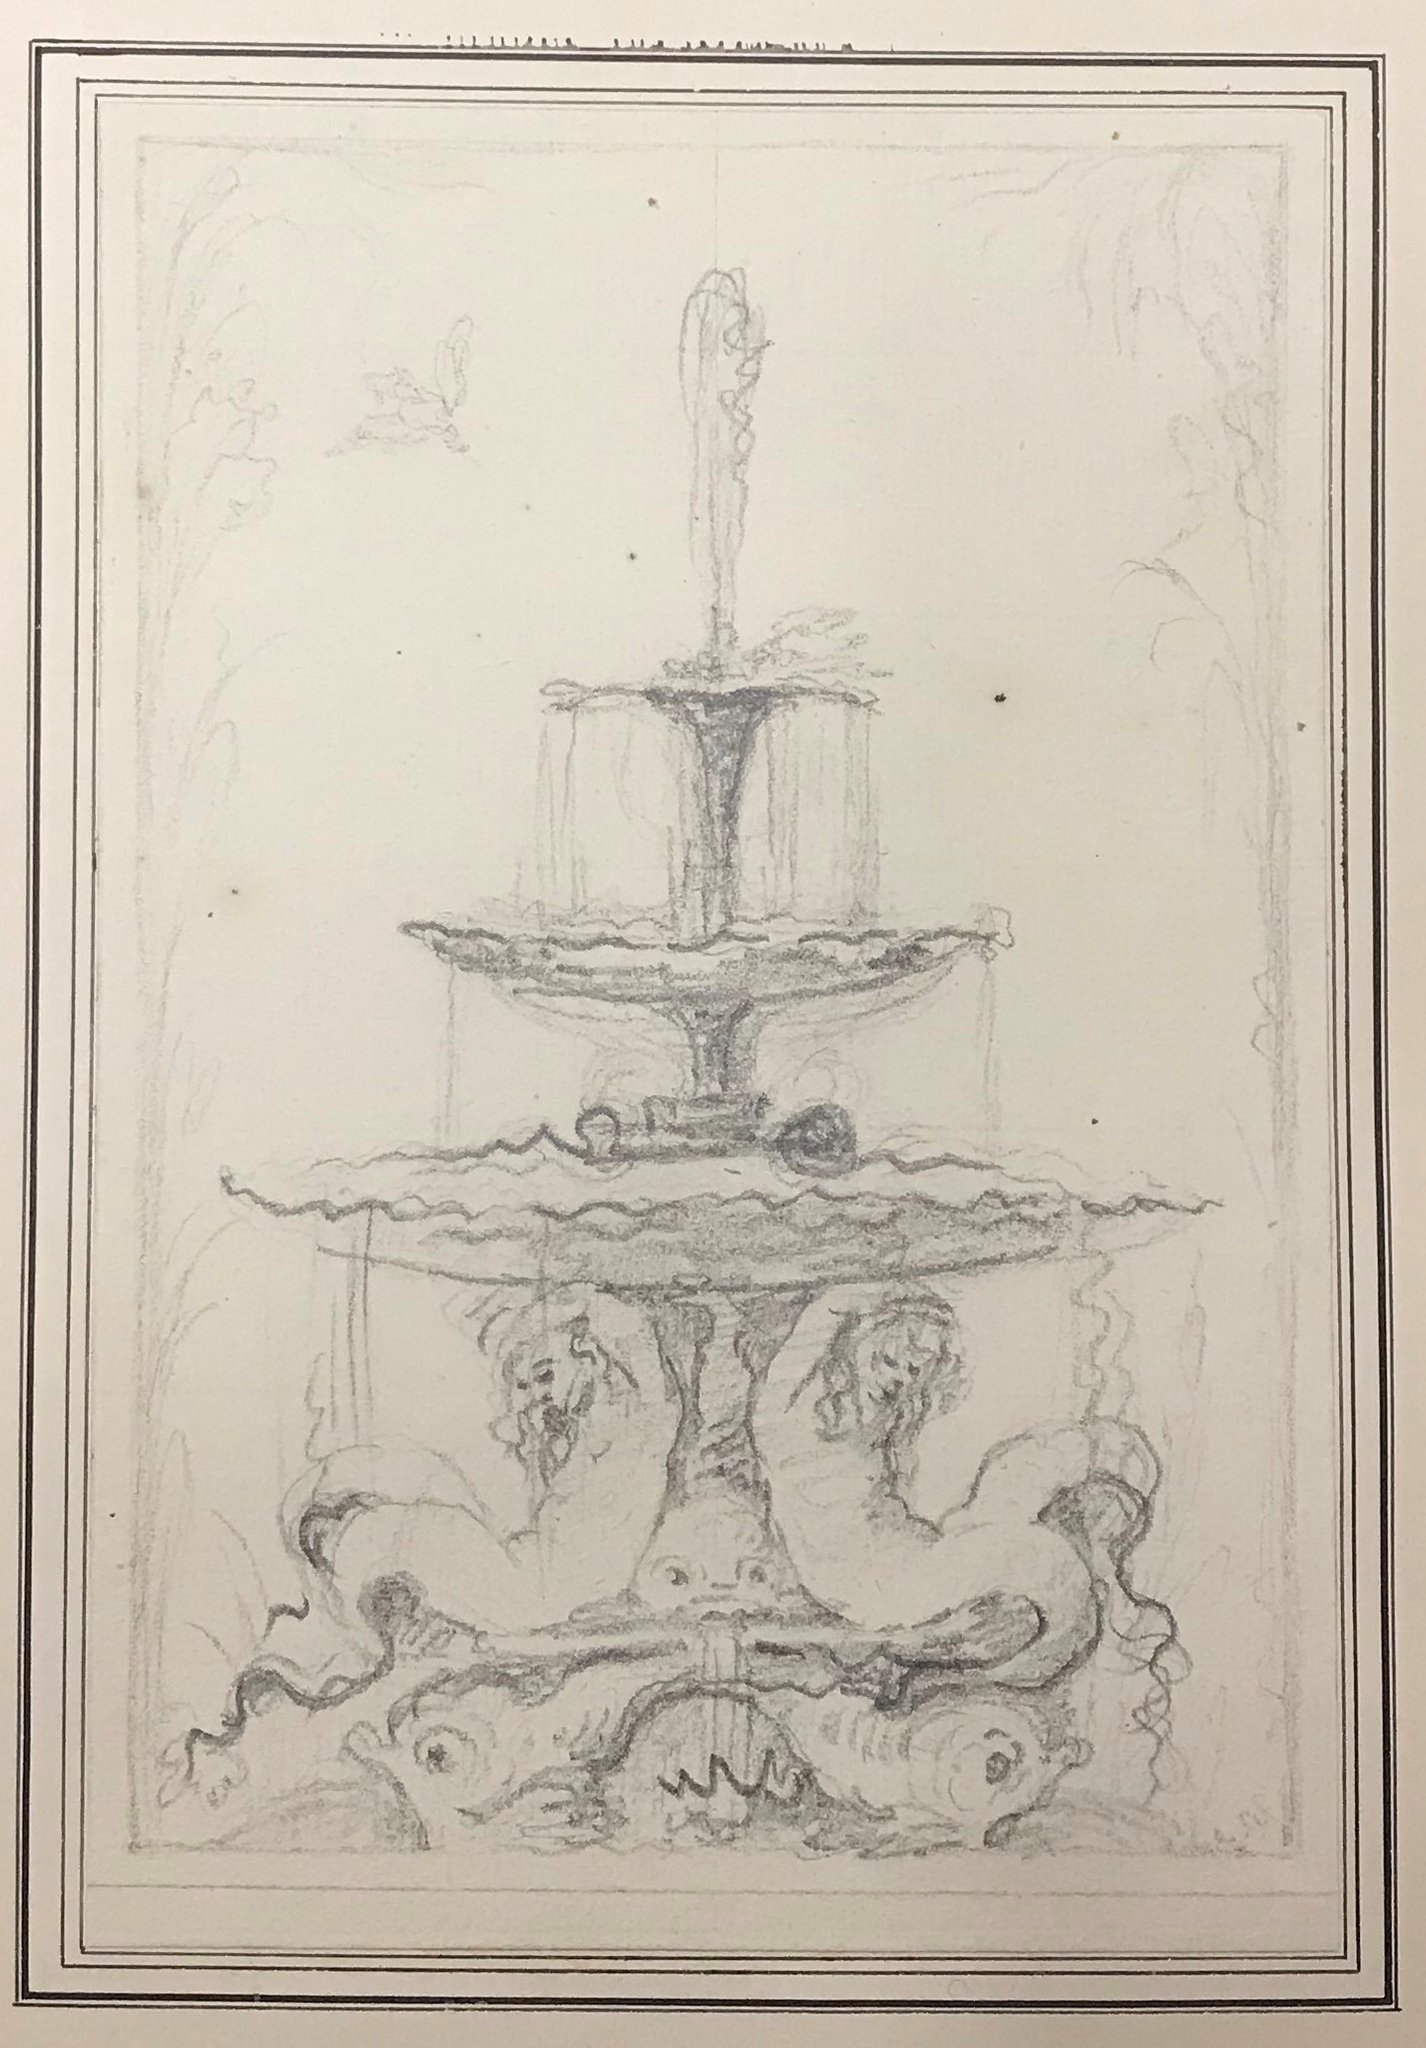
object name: album print ornament architecture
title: Album with Designs for Ornament and Various Objects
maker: gilles paul cauvet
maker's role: artist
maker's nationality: french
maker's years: 1731-1788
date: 1701-1800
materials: chalk, graphite, ink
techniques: pen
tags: fountains